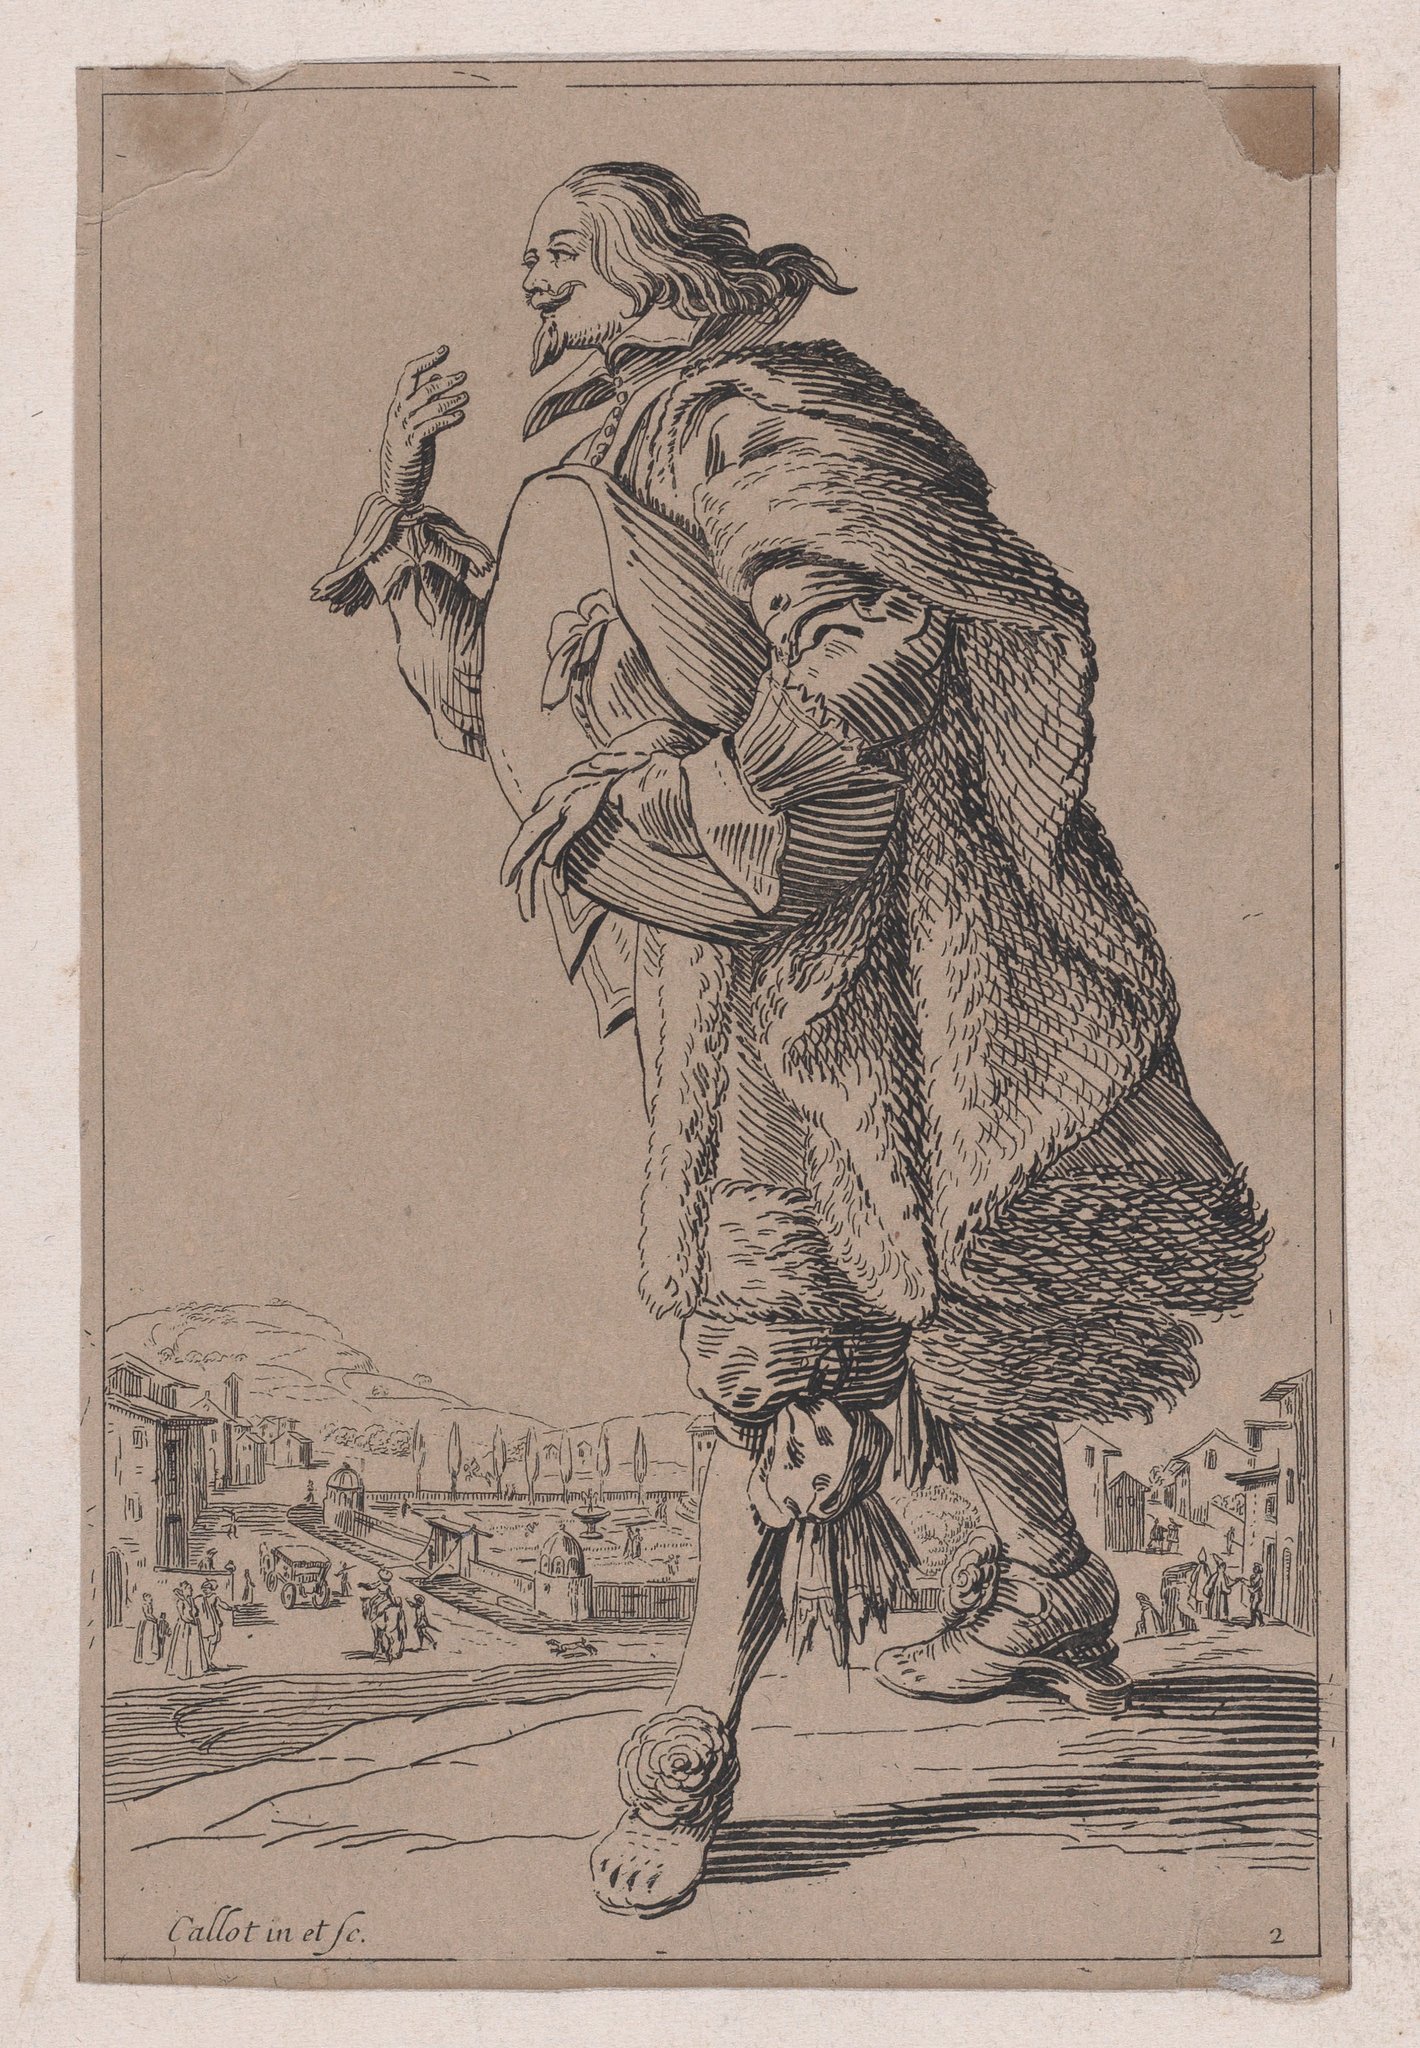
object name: print62. 635. 596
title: Copy of Le Gentilhomme qui Salue Tenant son Feutre sous le Bras (The Gentleman who Bows Holding his Felt Hat Under his Arm), from "La Noblesse" (The Nobility)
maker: Anonymous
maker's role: artist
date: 1601-1700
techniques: etching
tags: men